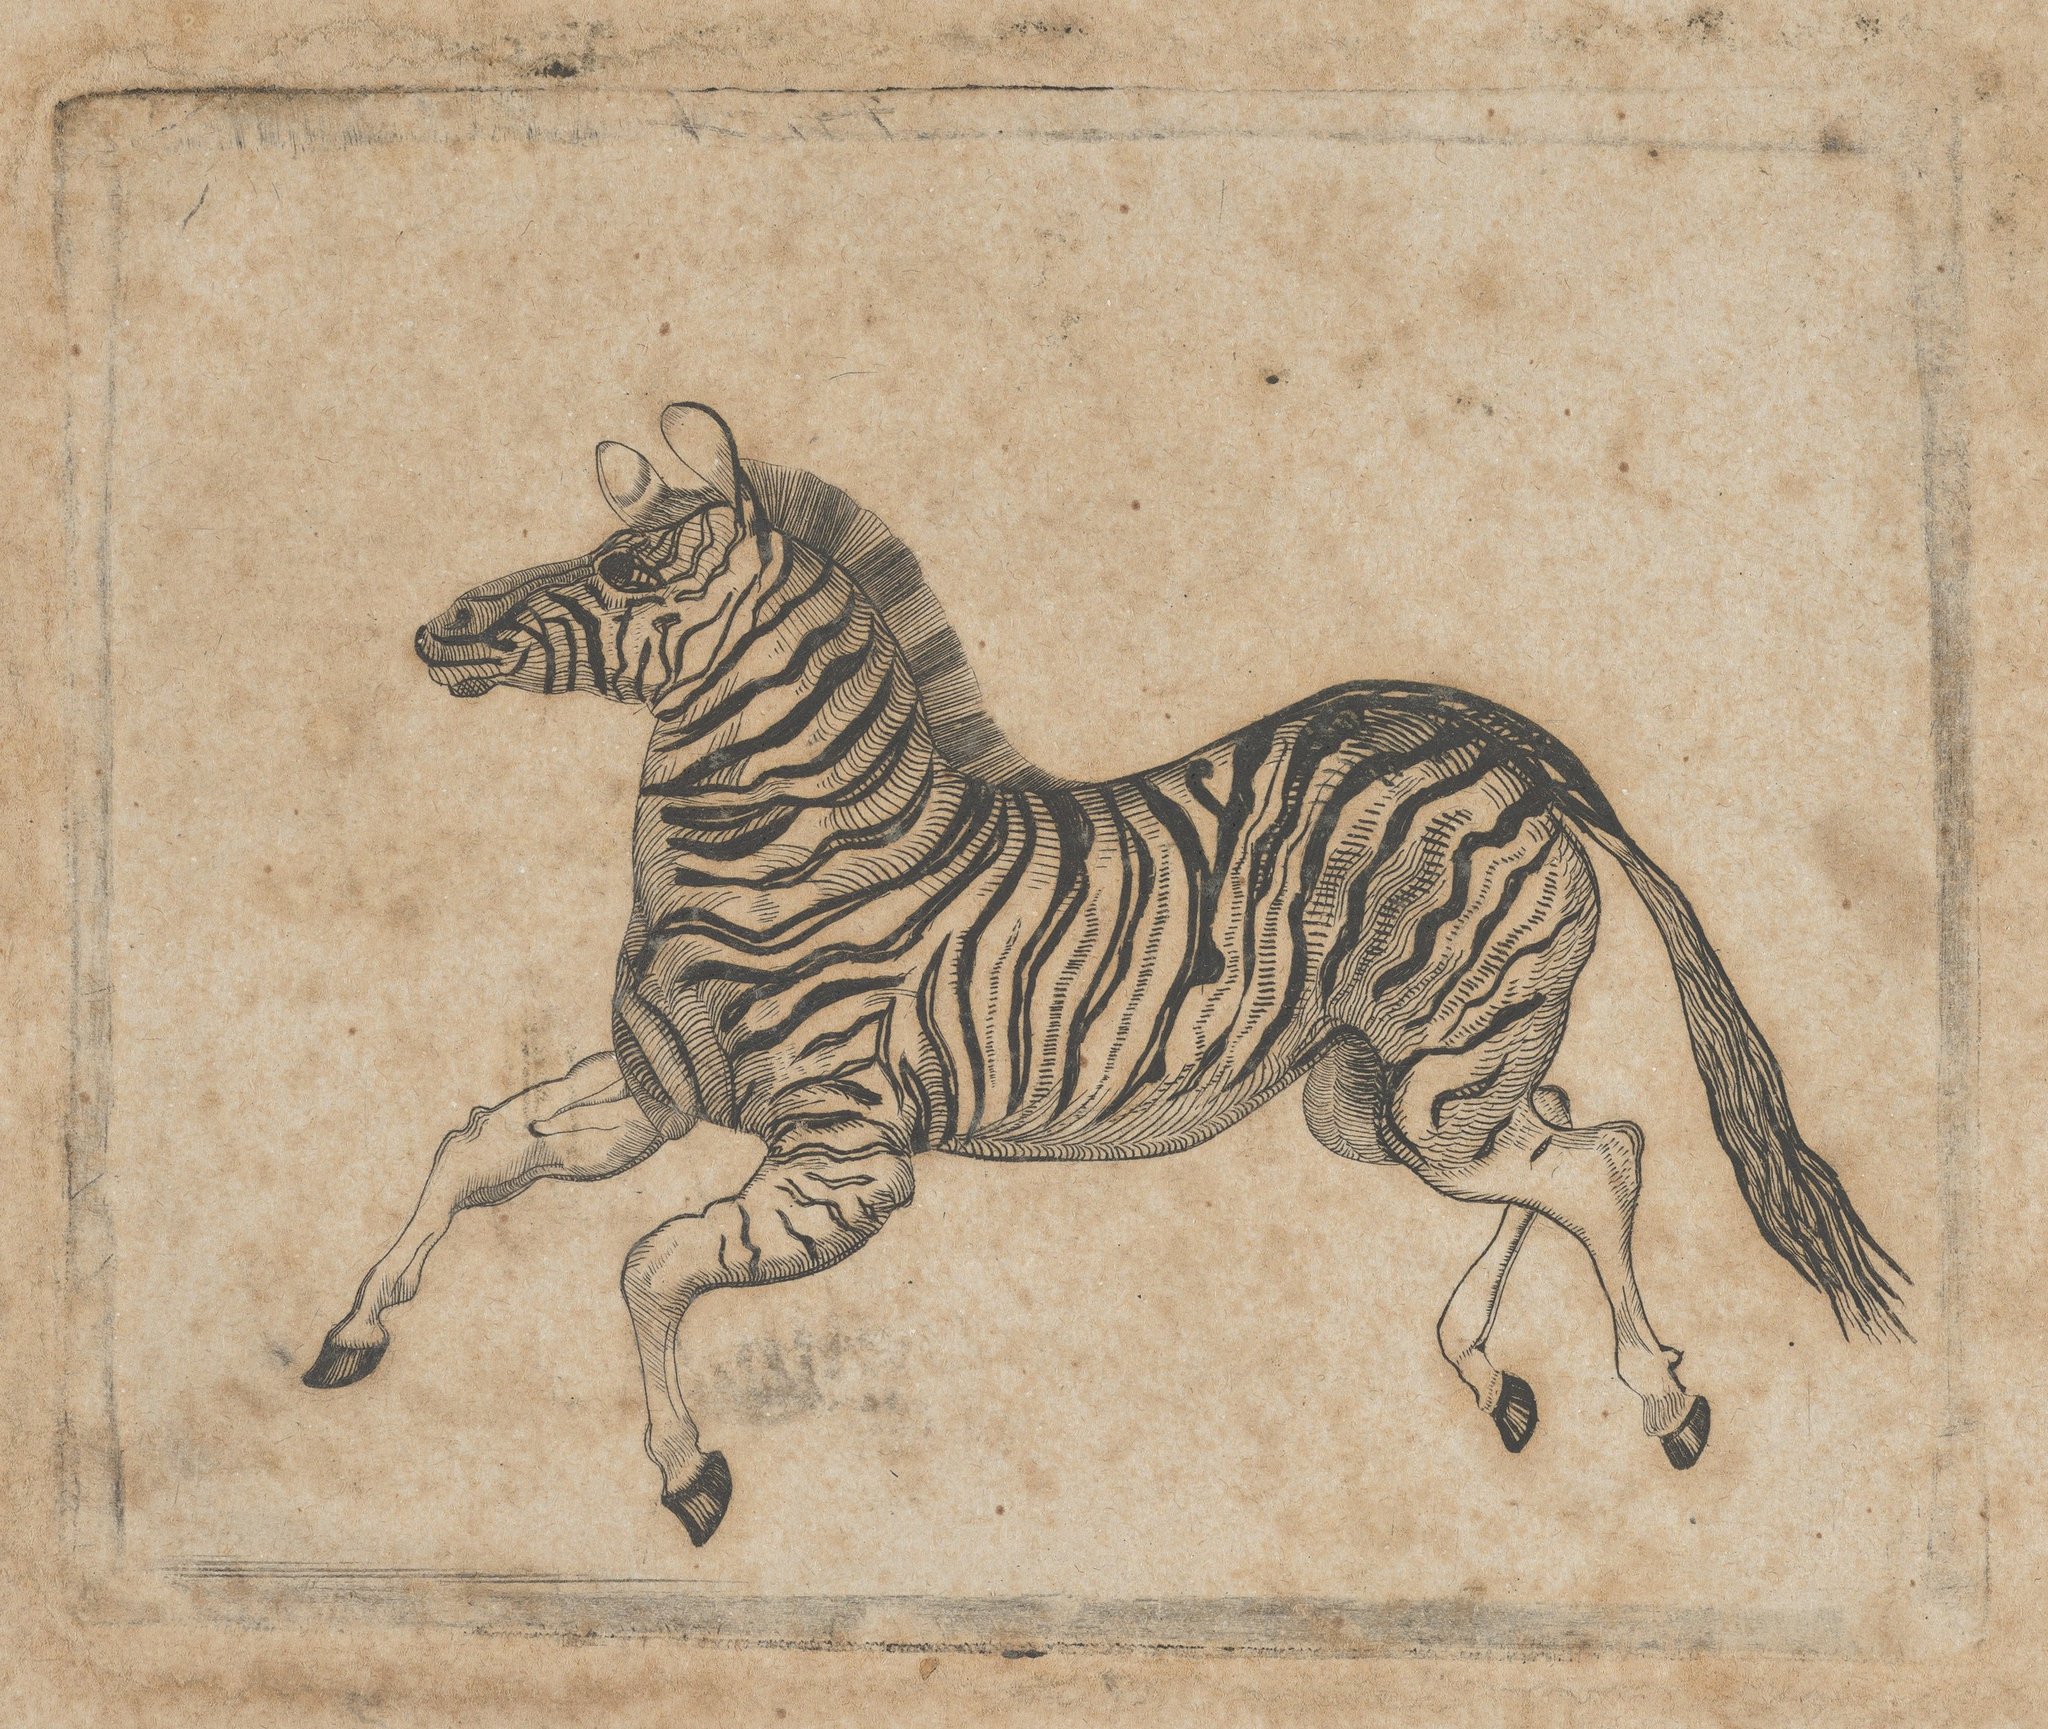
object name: print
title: Banknote vignette showing a zebra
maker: asher brown durand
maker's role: artist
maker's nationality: american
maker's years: 1796-1886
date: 1824-1837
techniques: etching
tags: zebras